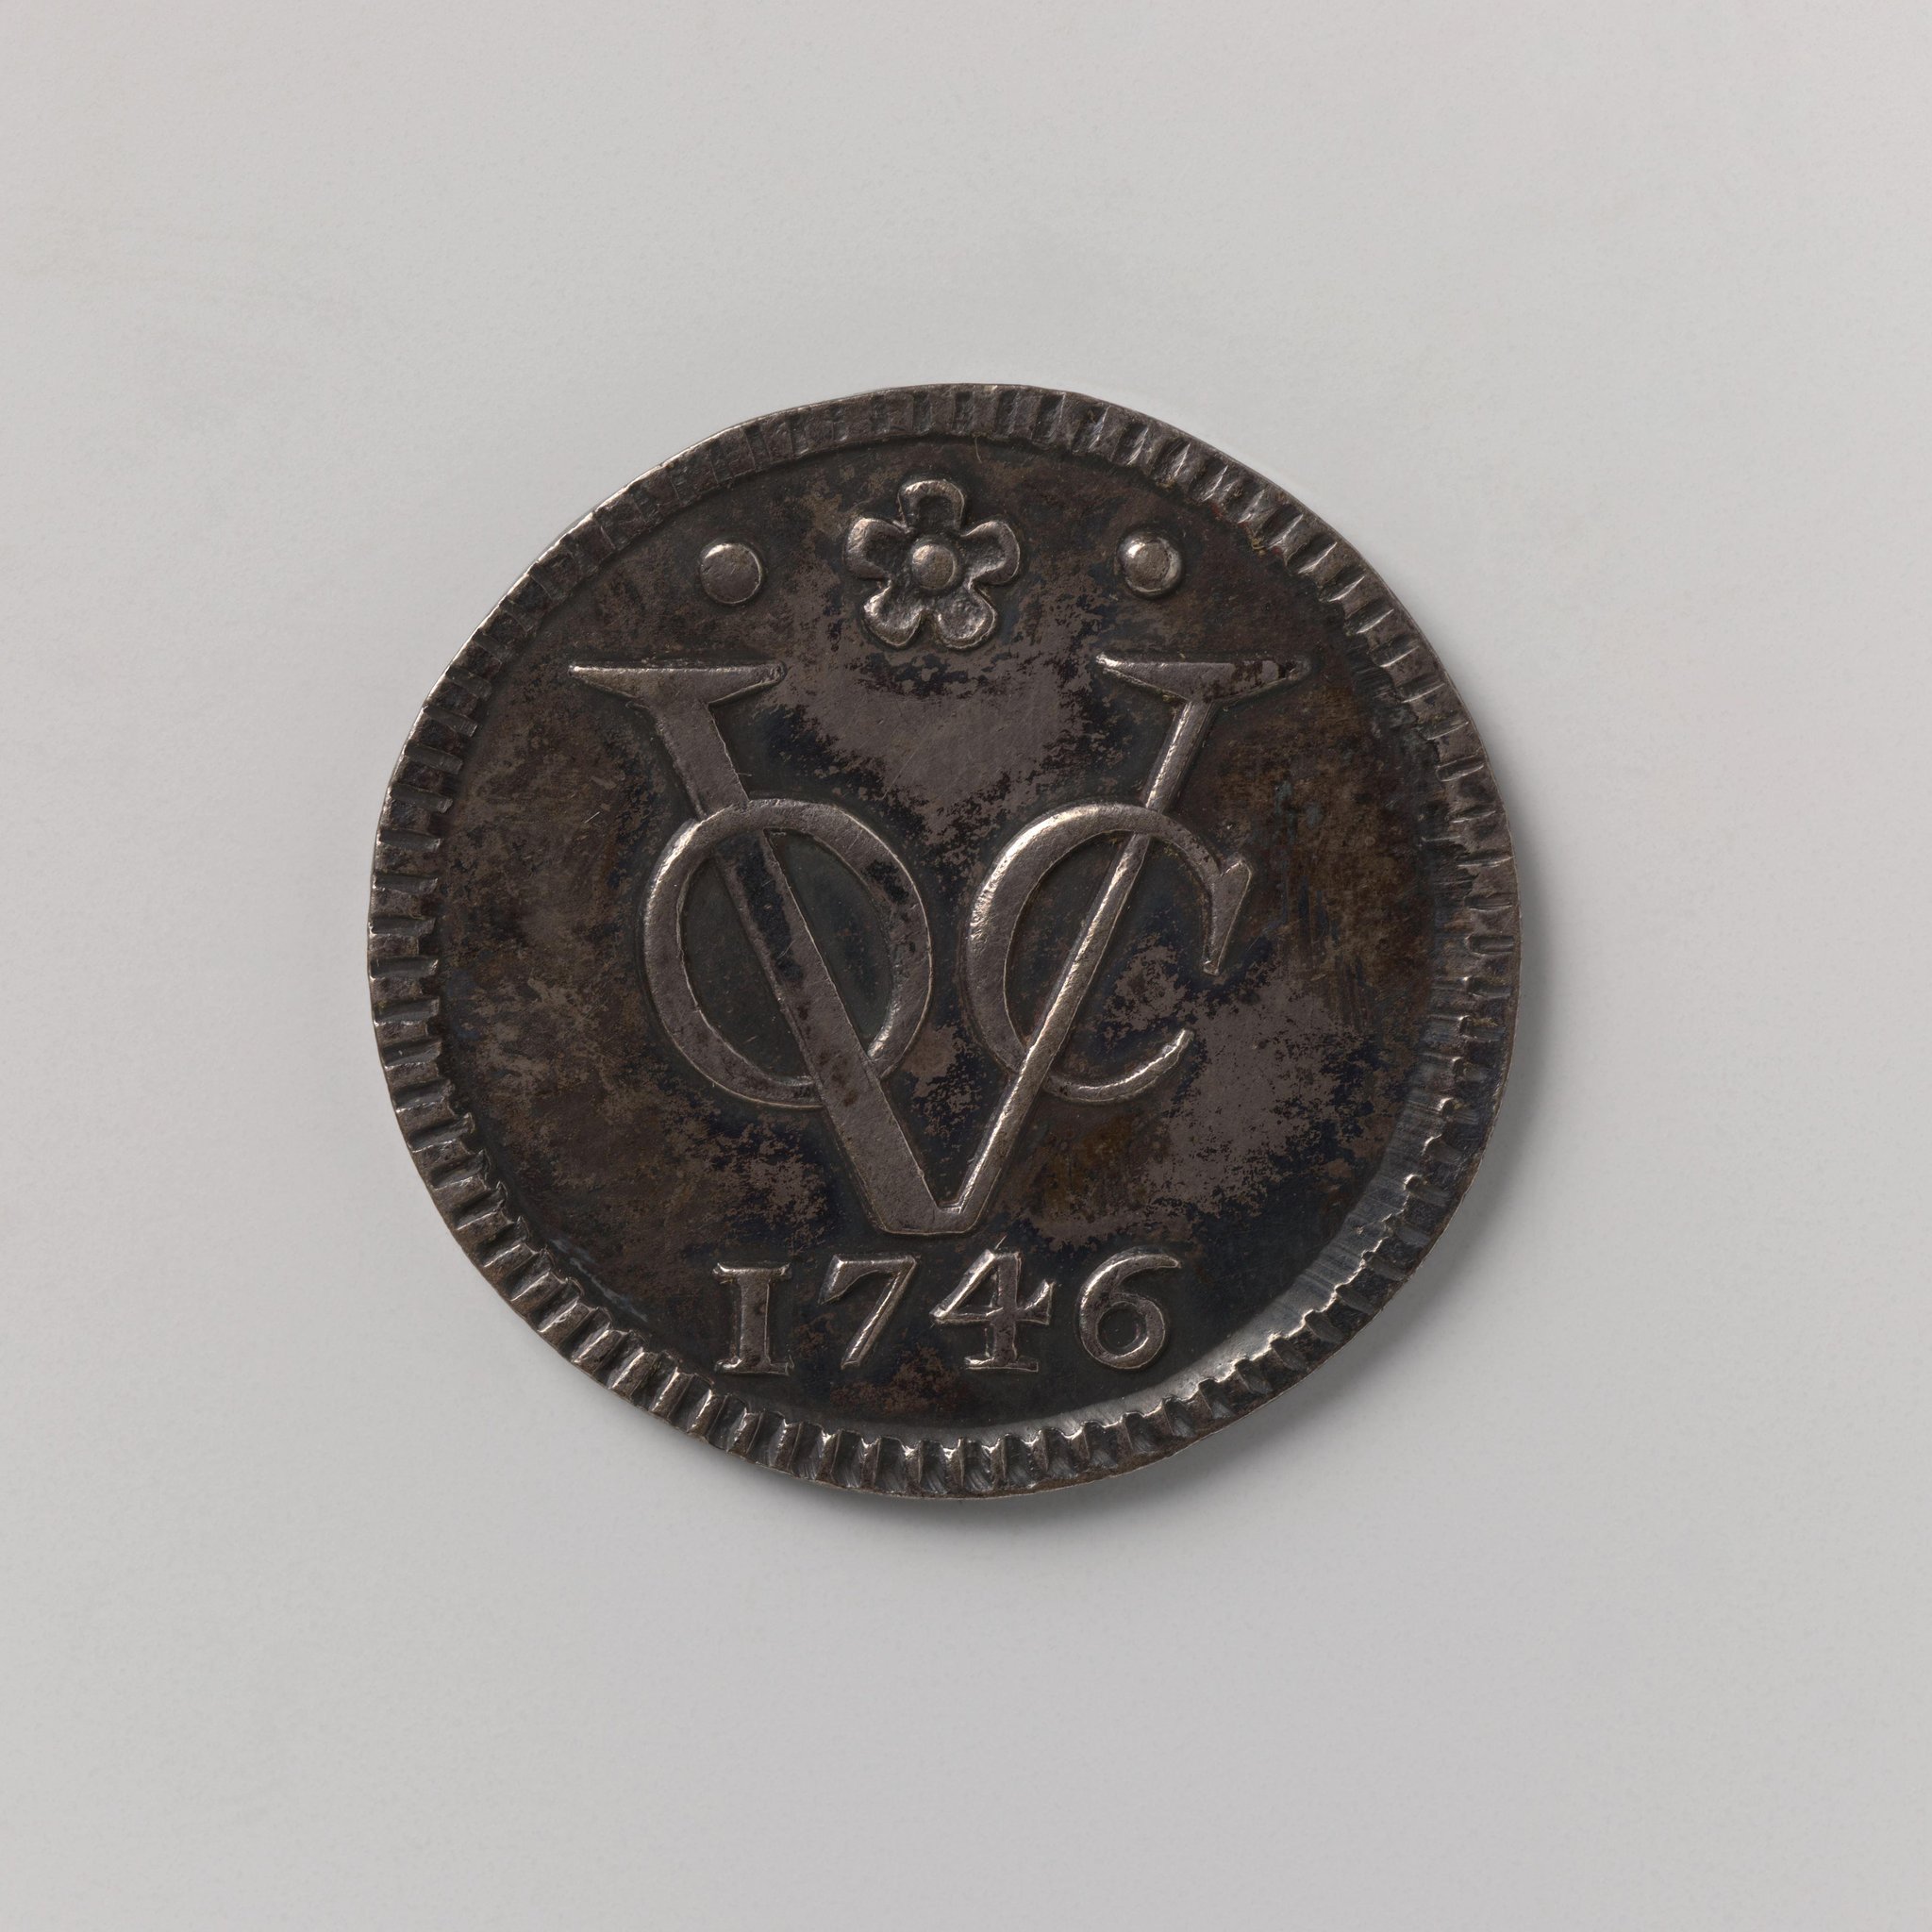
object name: coin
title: VOC, duit Holland, 1746. Afslag in zilver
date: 1746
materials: silver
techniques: striking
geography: dordrecht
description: Zilveren munt. Voorzijde: gekroond wapenschild van Holland. Keerzijde: monogram van de VOC, waarboven muntteken en waaronder jaartal. Gladde rand. Afslag in zilver.